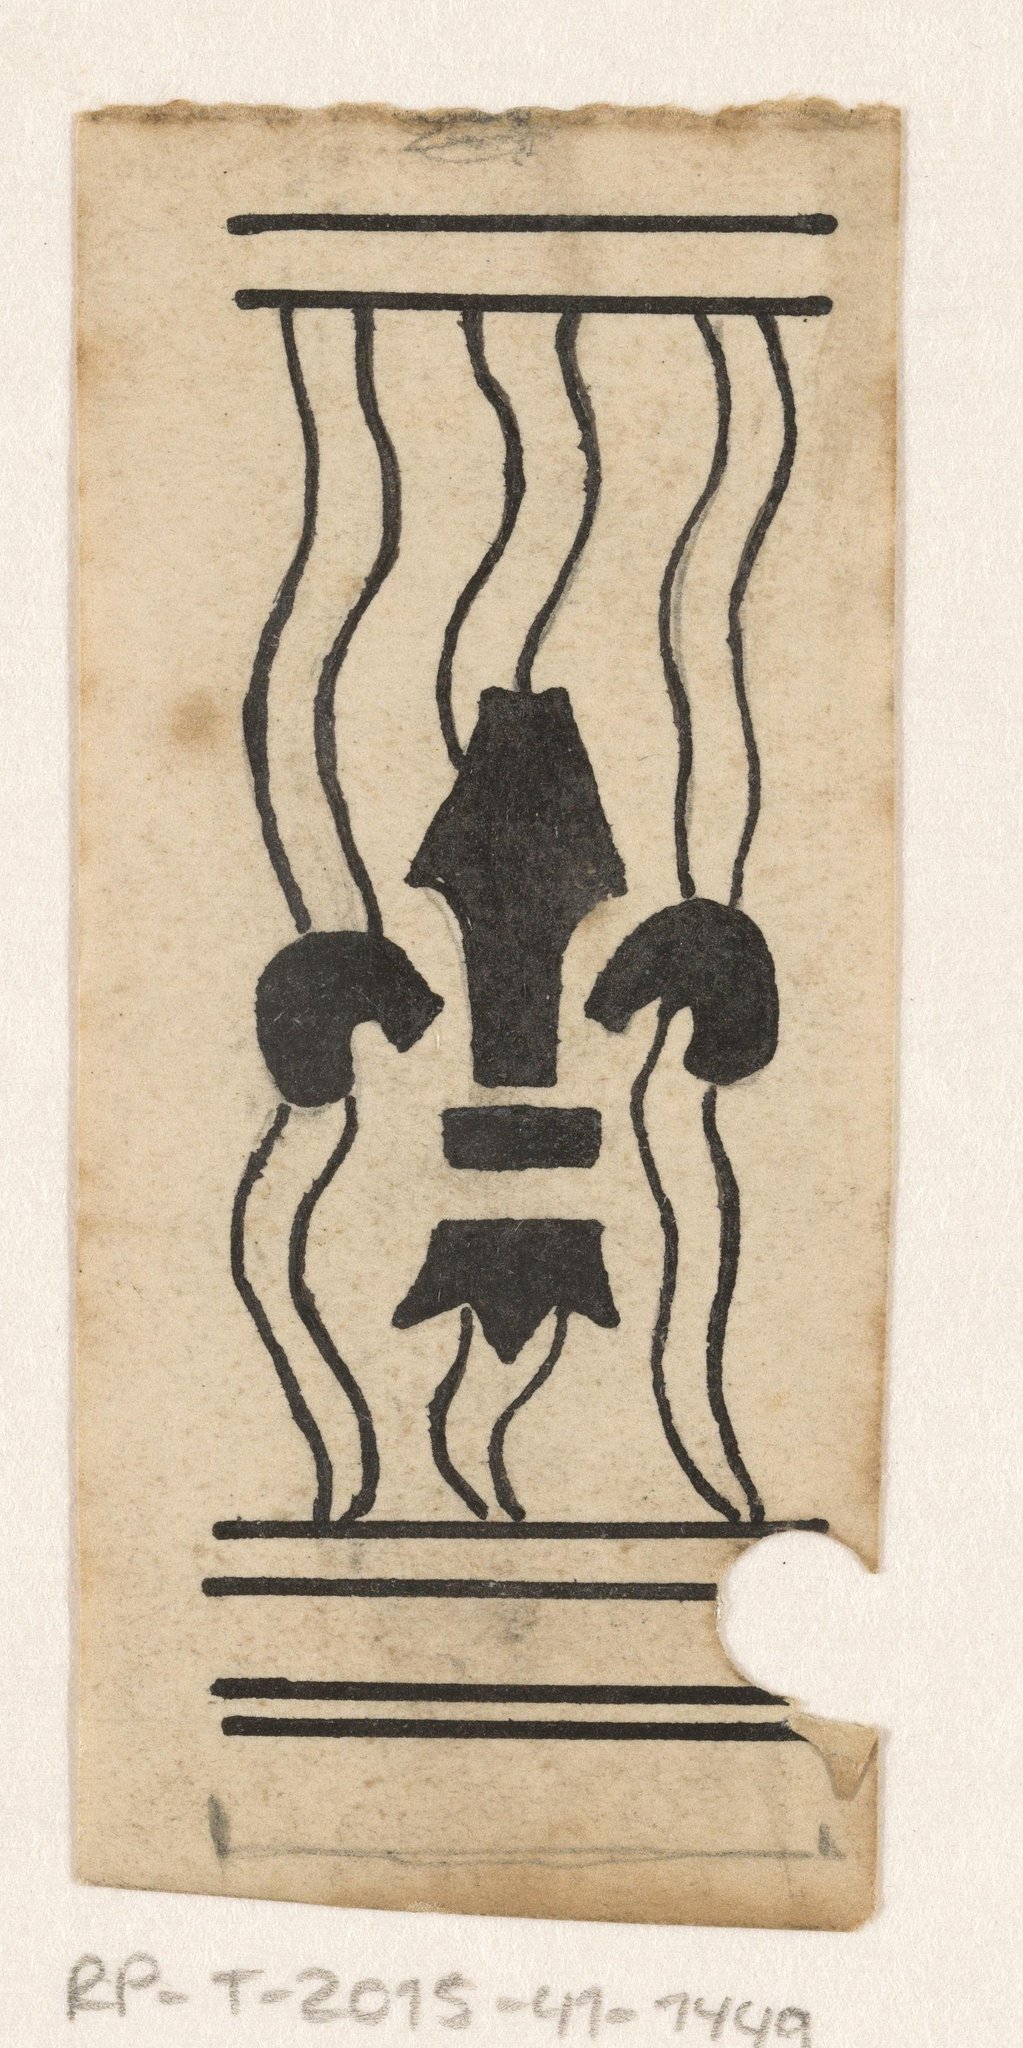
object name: drawing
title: Bandontwerp voor: Louis Couperus, Majesteit, 1893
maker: richard nicolaüs roland holst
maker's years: 1868-1938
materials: ink, paper, pencil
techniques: brush, pen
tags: fleur-de-lis ~ ornament, trees (+ root, tuber)